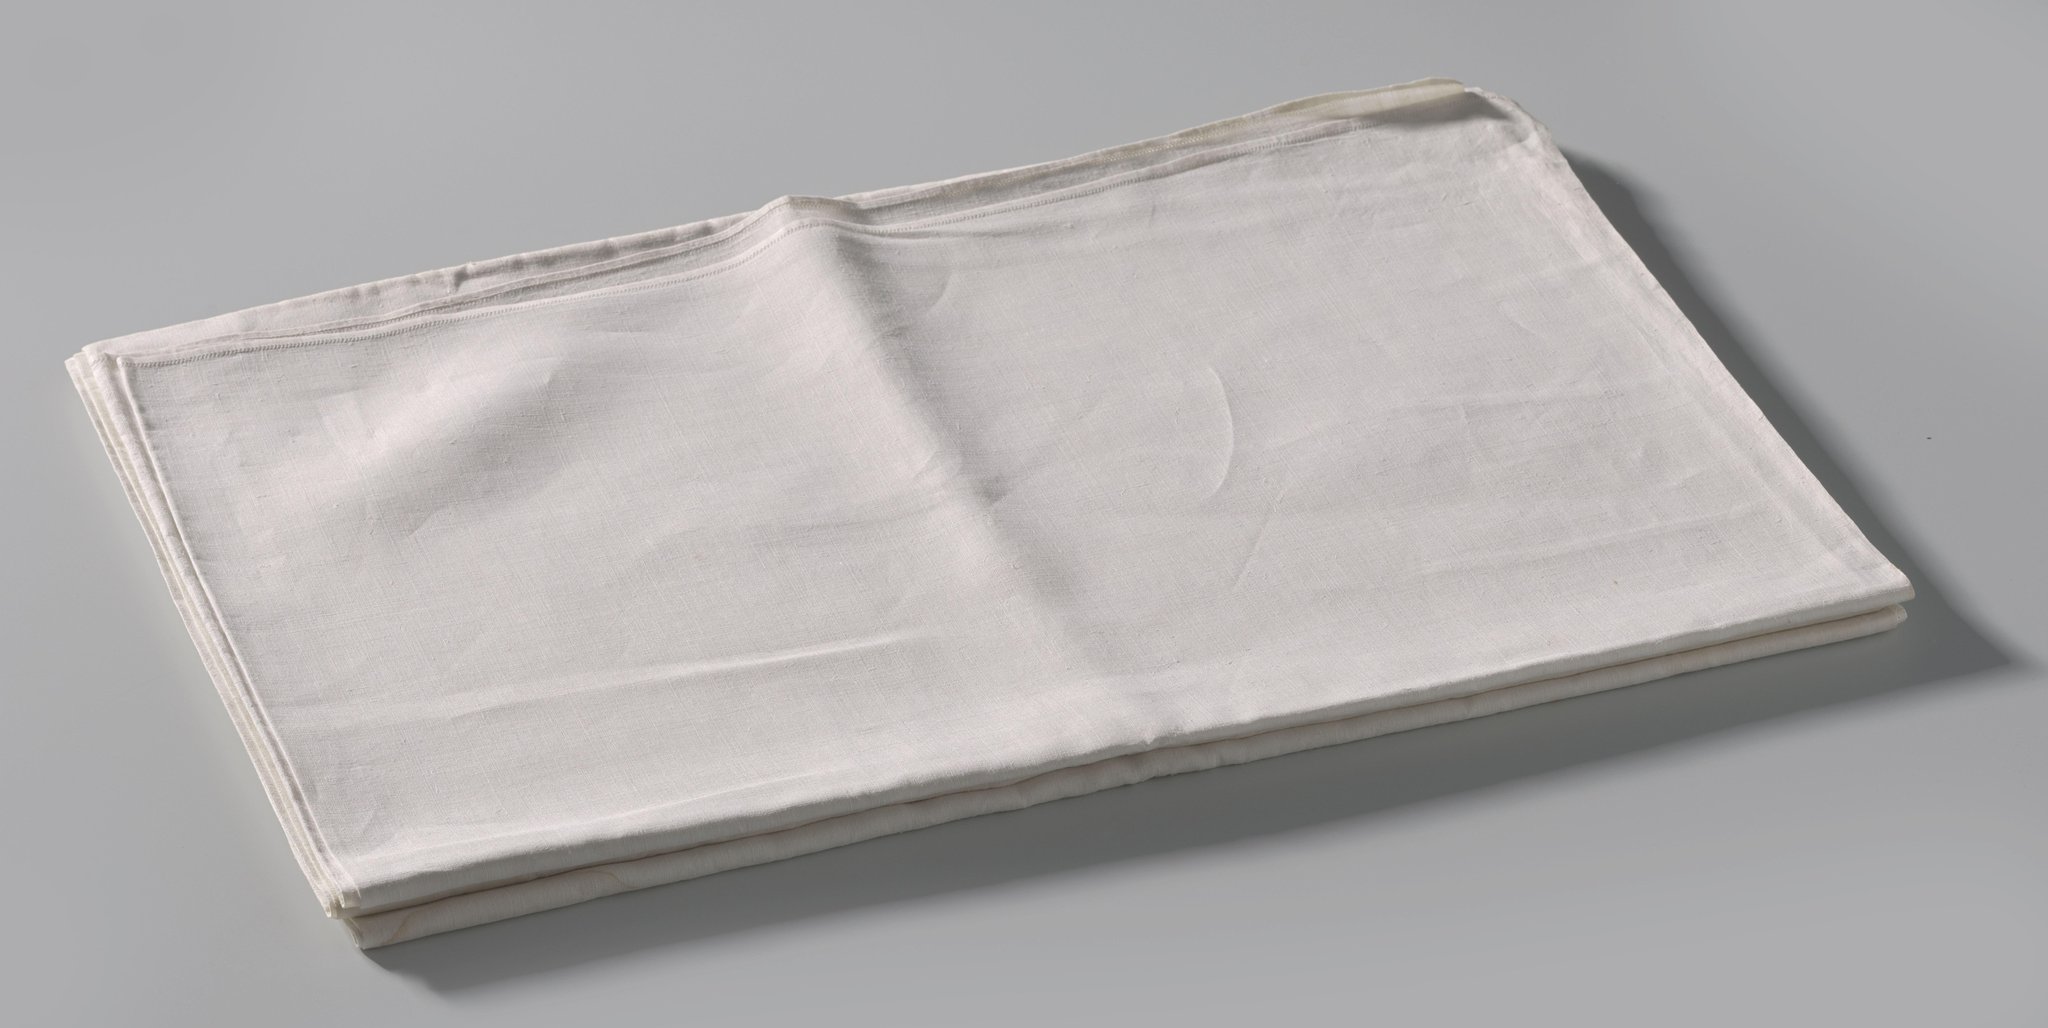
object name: beddenlaken, laken object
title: Laken met entre-deux met bloem- en bladmotieven en open zomen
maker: Anonymous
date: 1650-1700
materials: linen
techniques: lace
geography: netherlands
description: Laken van fijn wit linnen met entre-deux van 'Hollandse' kloskant met bloem- en bladmotiefjes en open zomen.